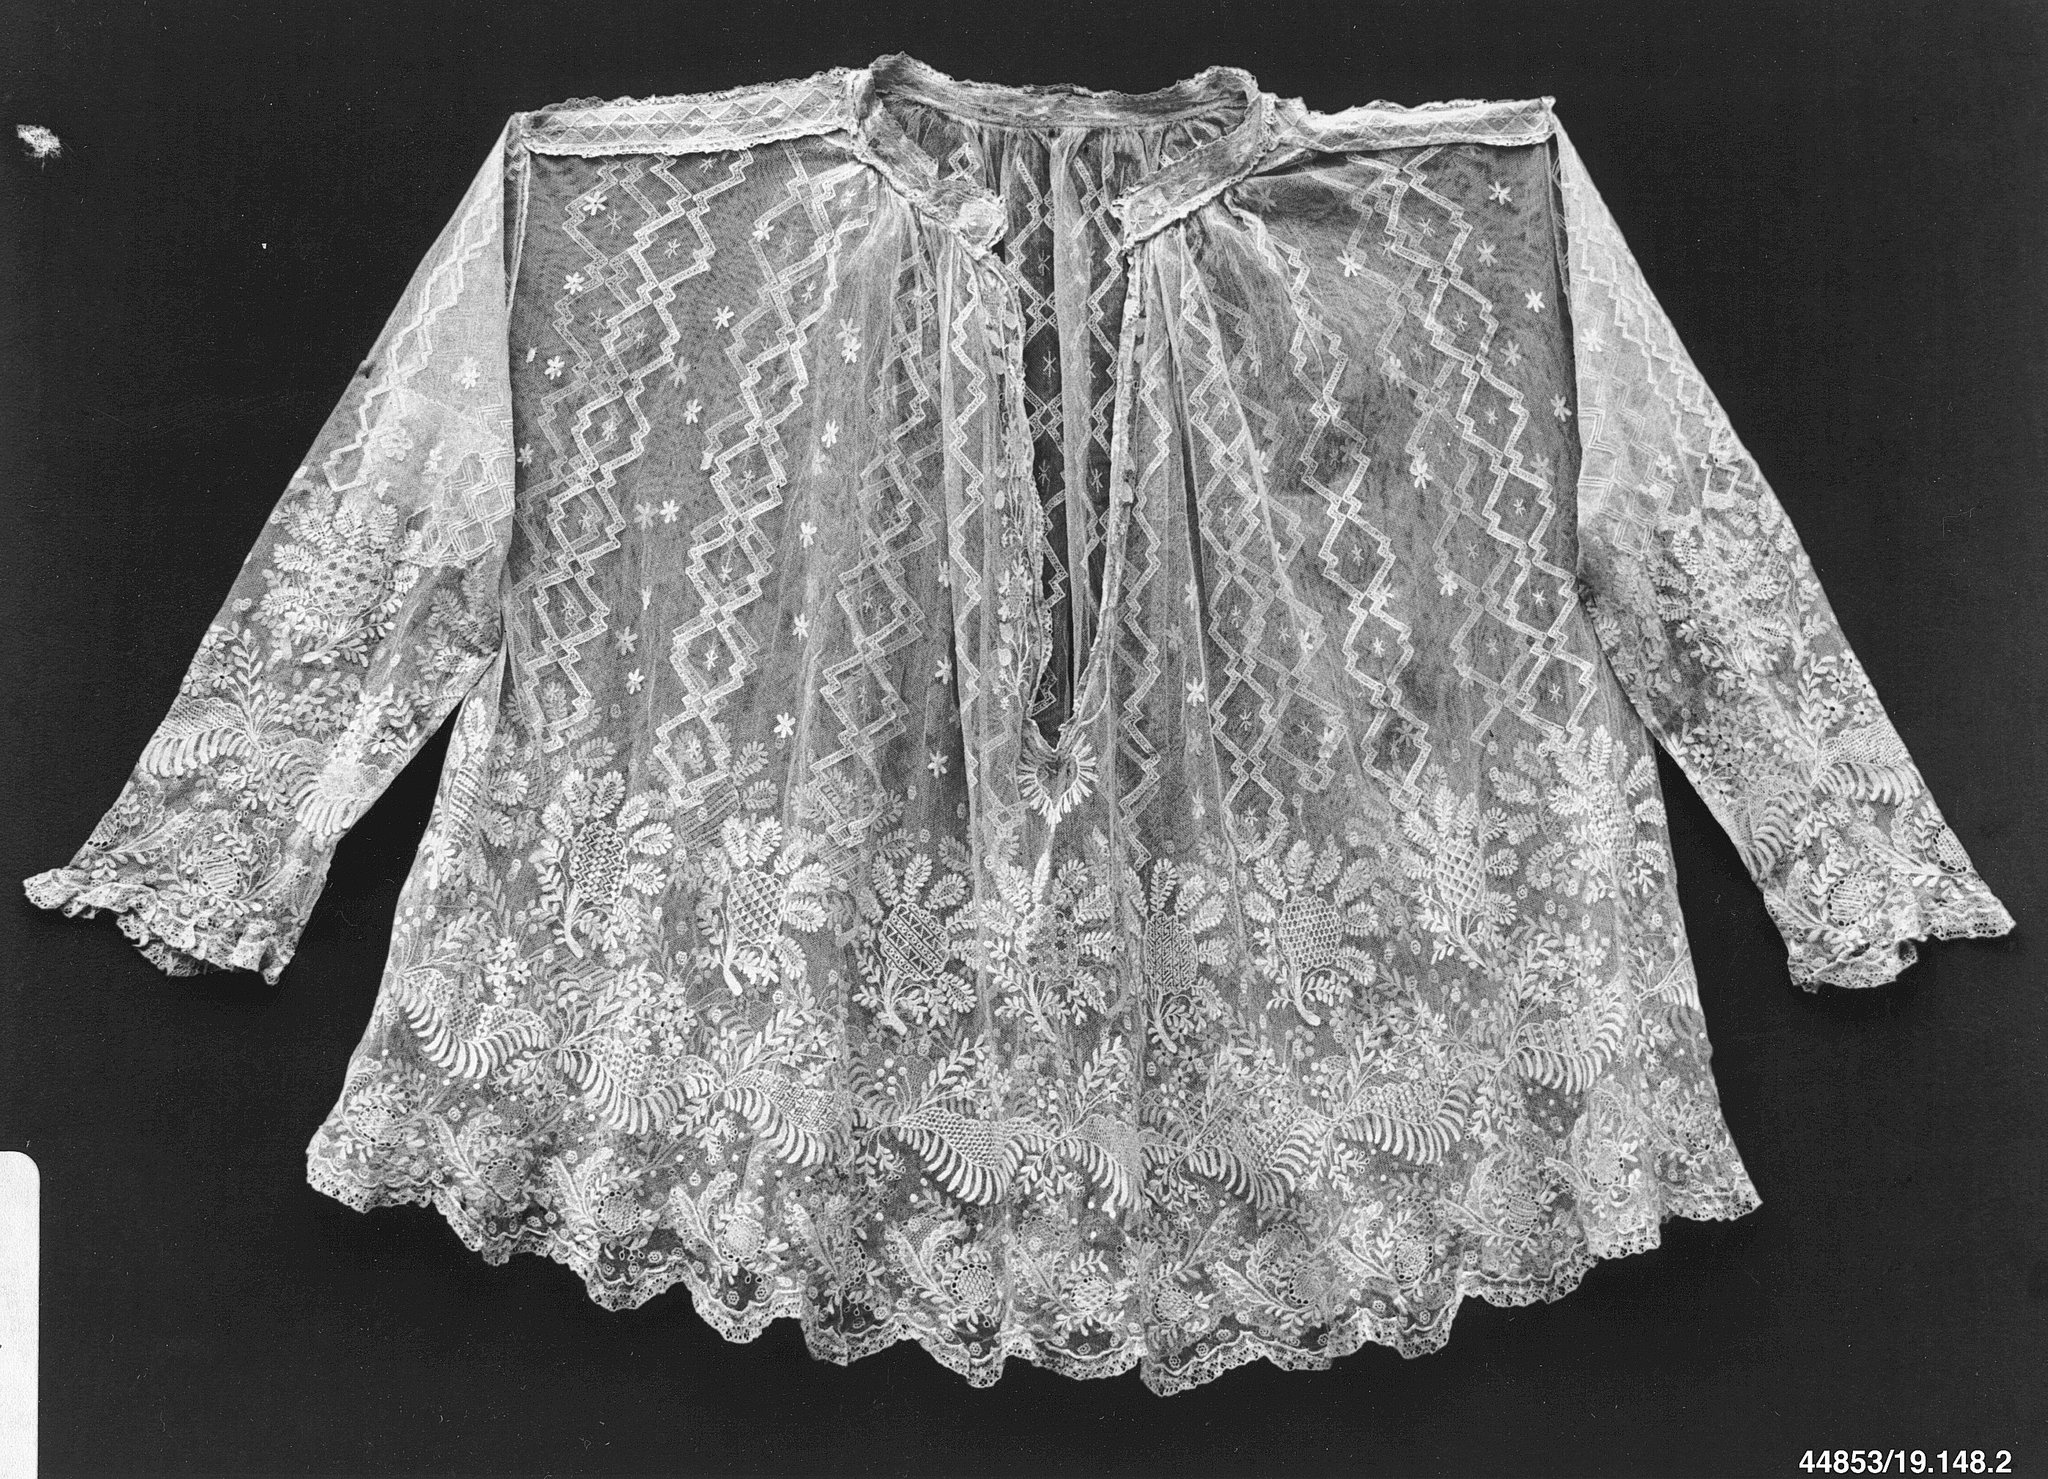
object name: surplice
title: Surplice (Cotta)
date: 1801-1900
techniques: embroidery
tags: flowers,leaves